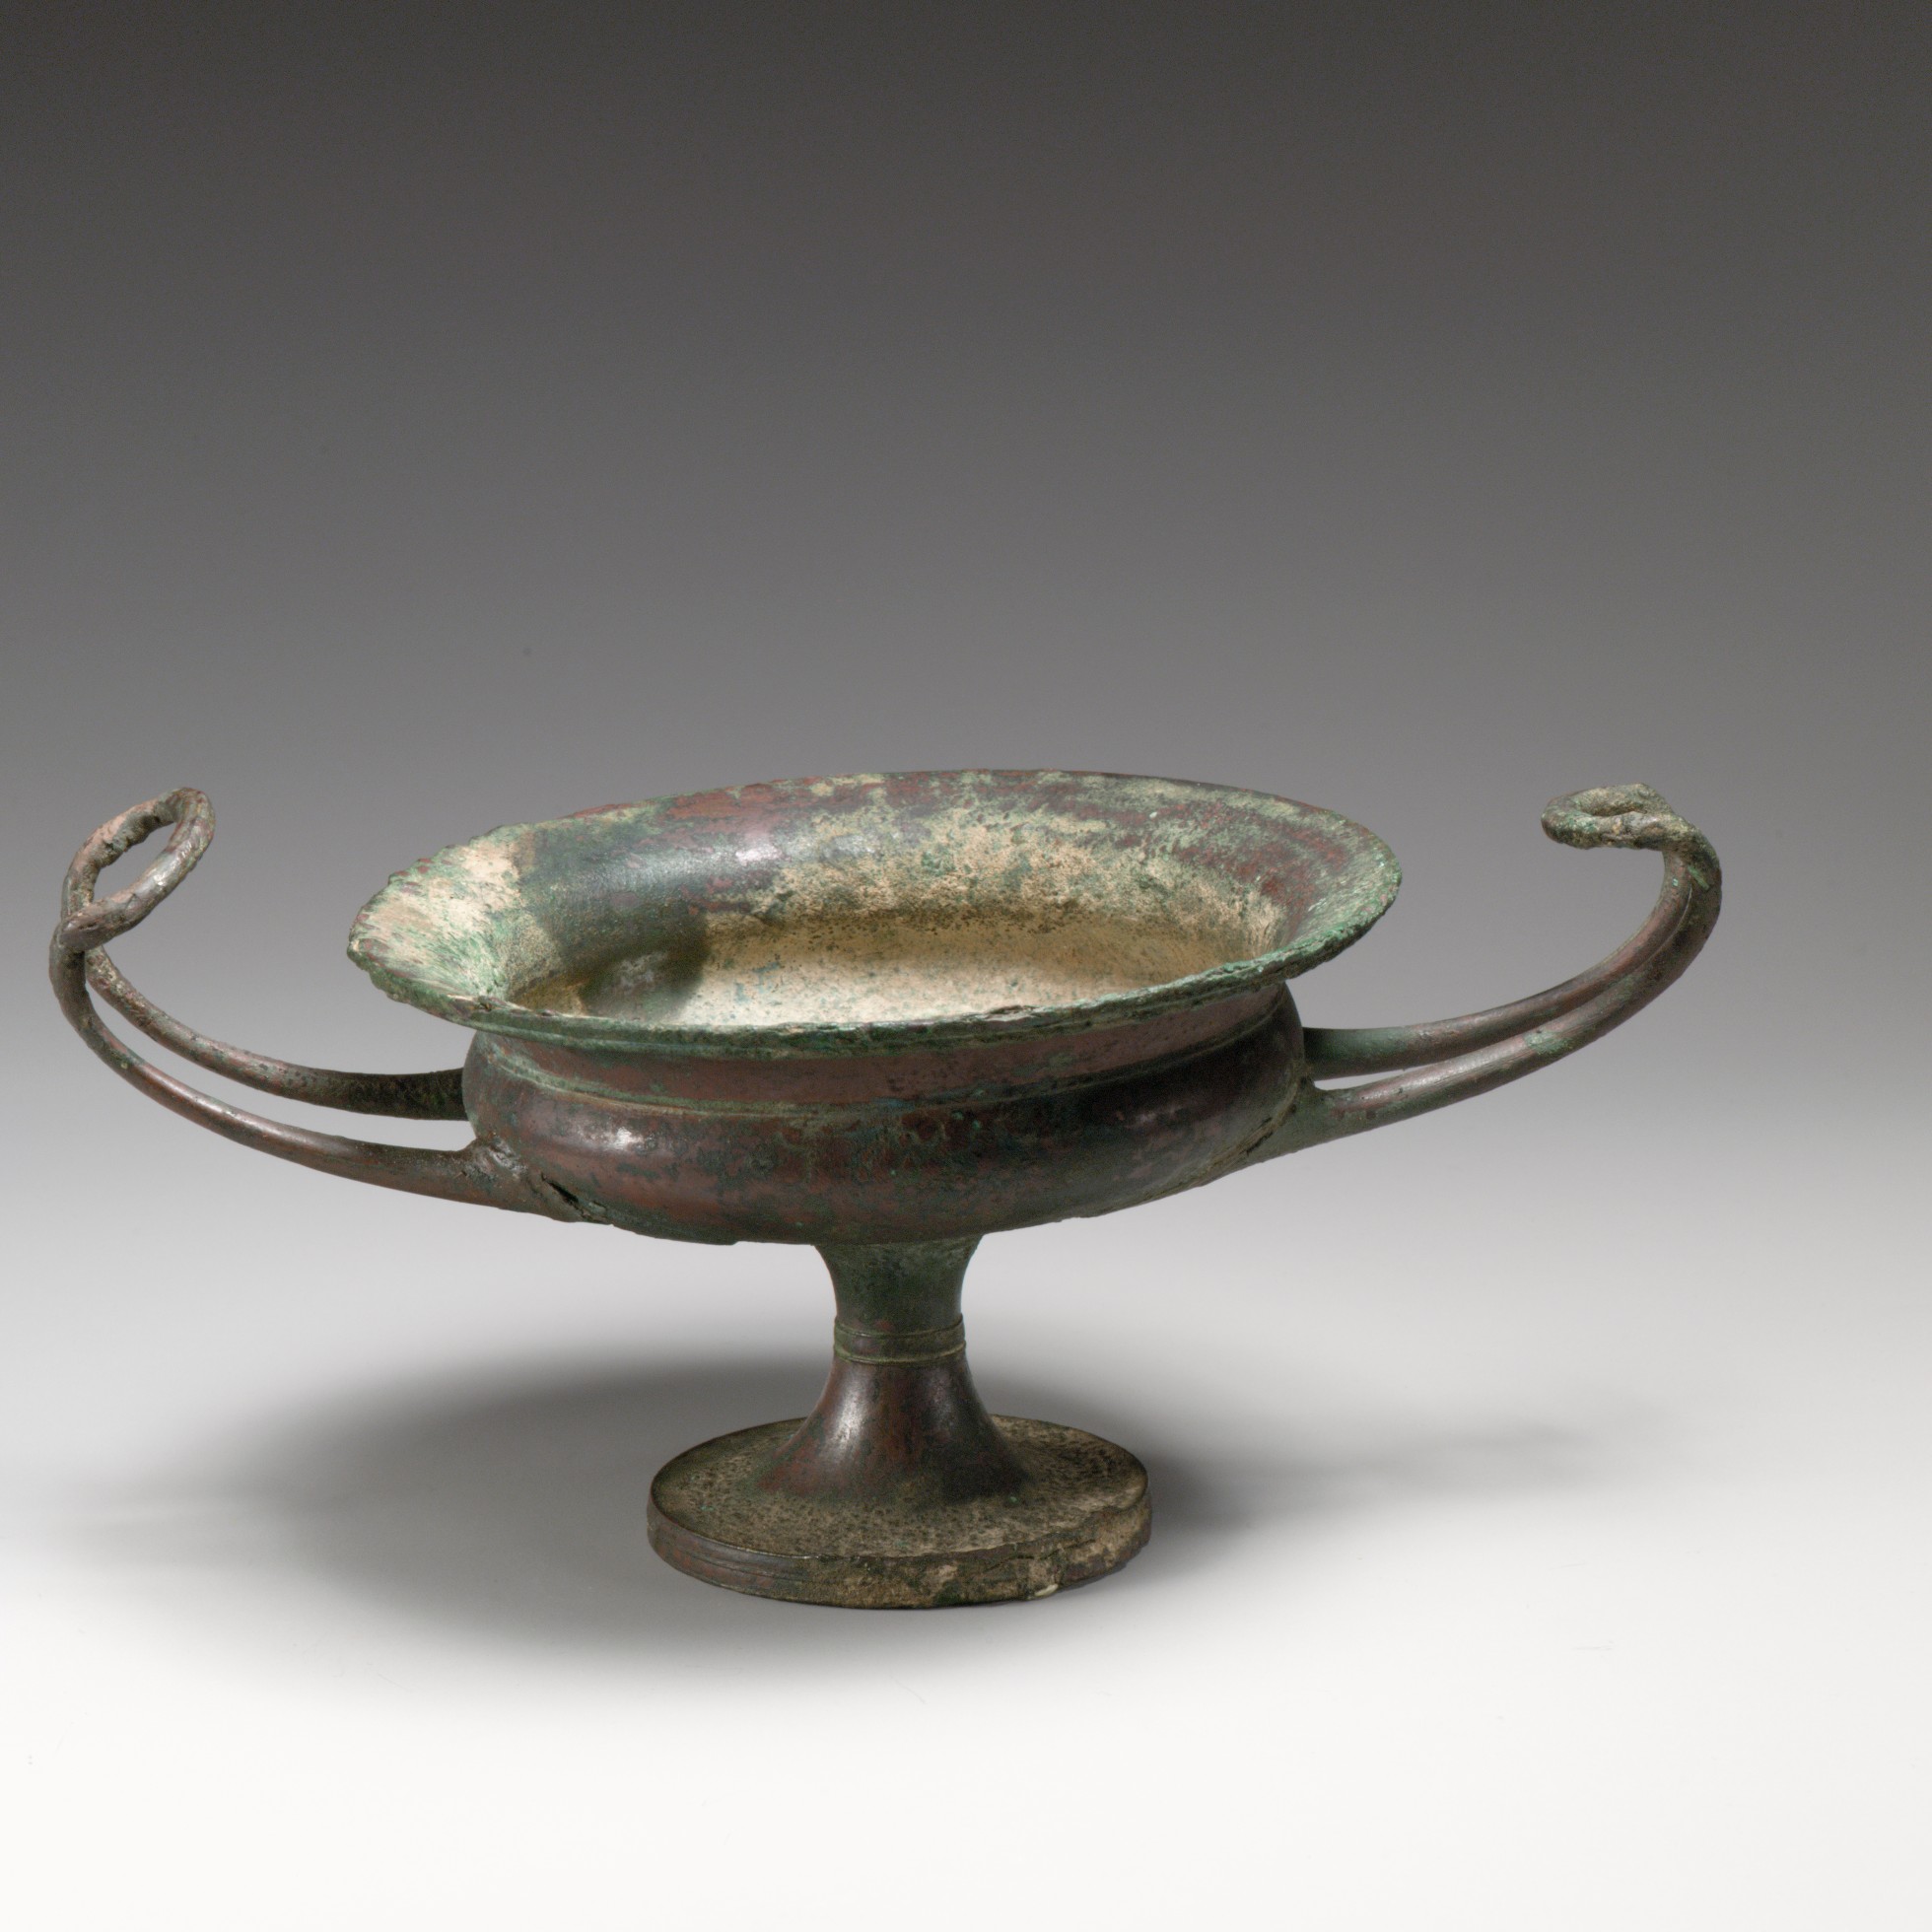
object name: kylix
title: Bronze kylix (drinking cup)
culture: greek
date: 334-301 BCE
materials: bronze